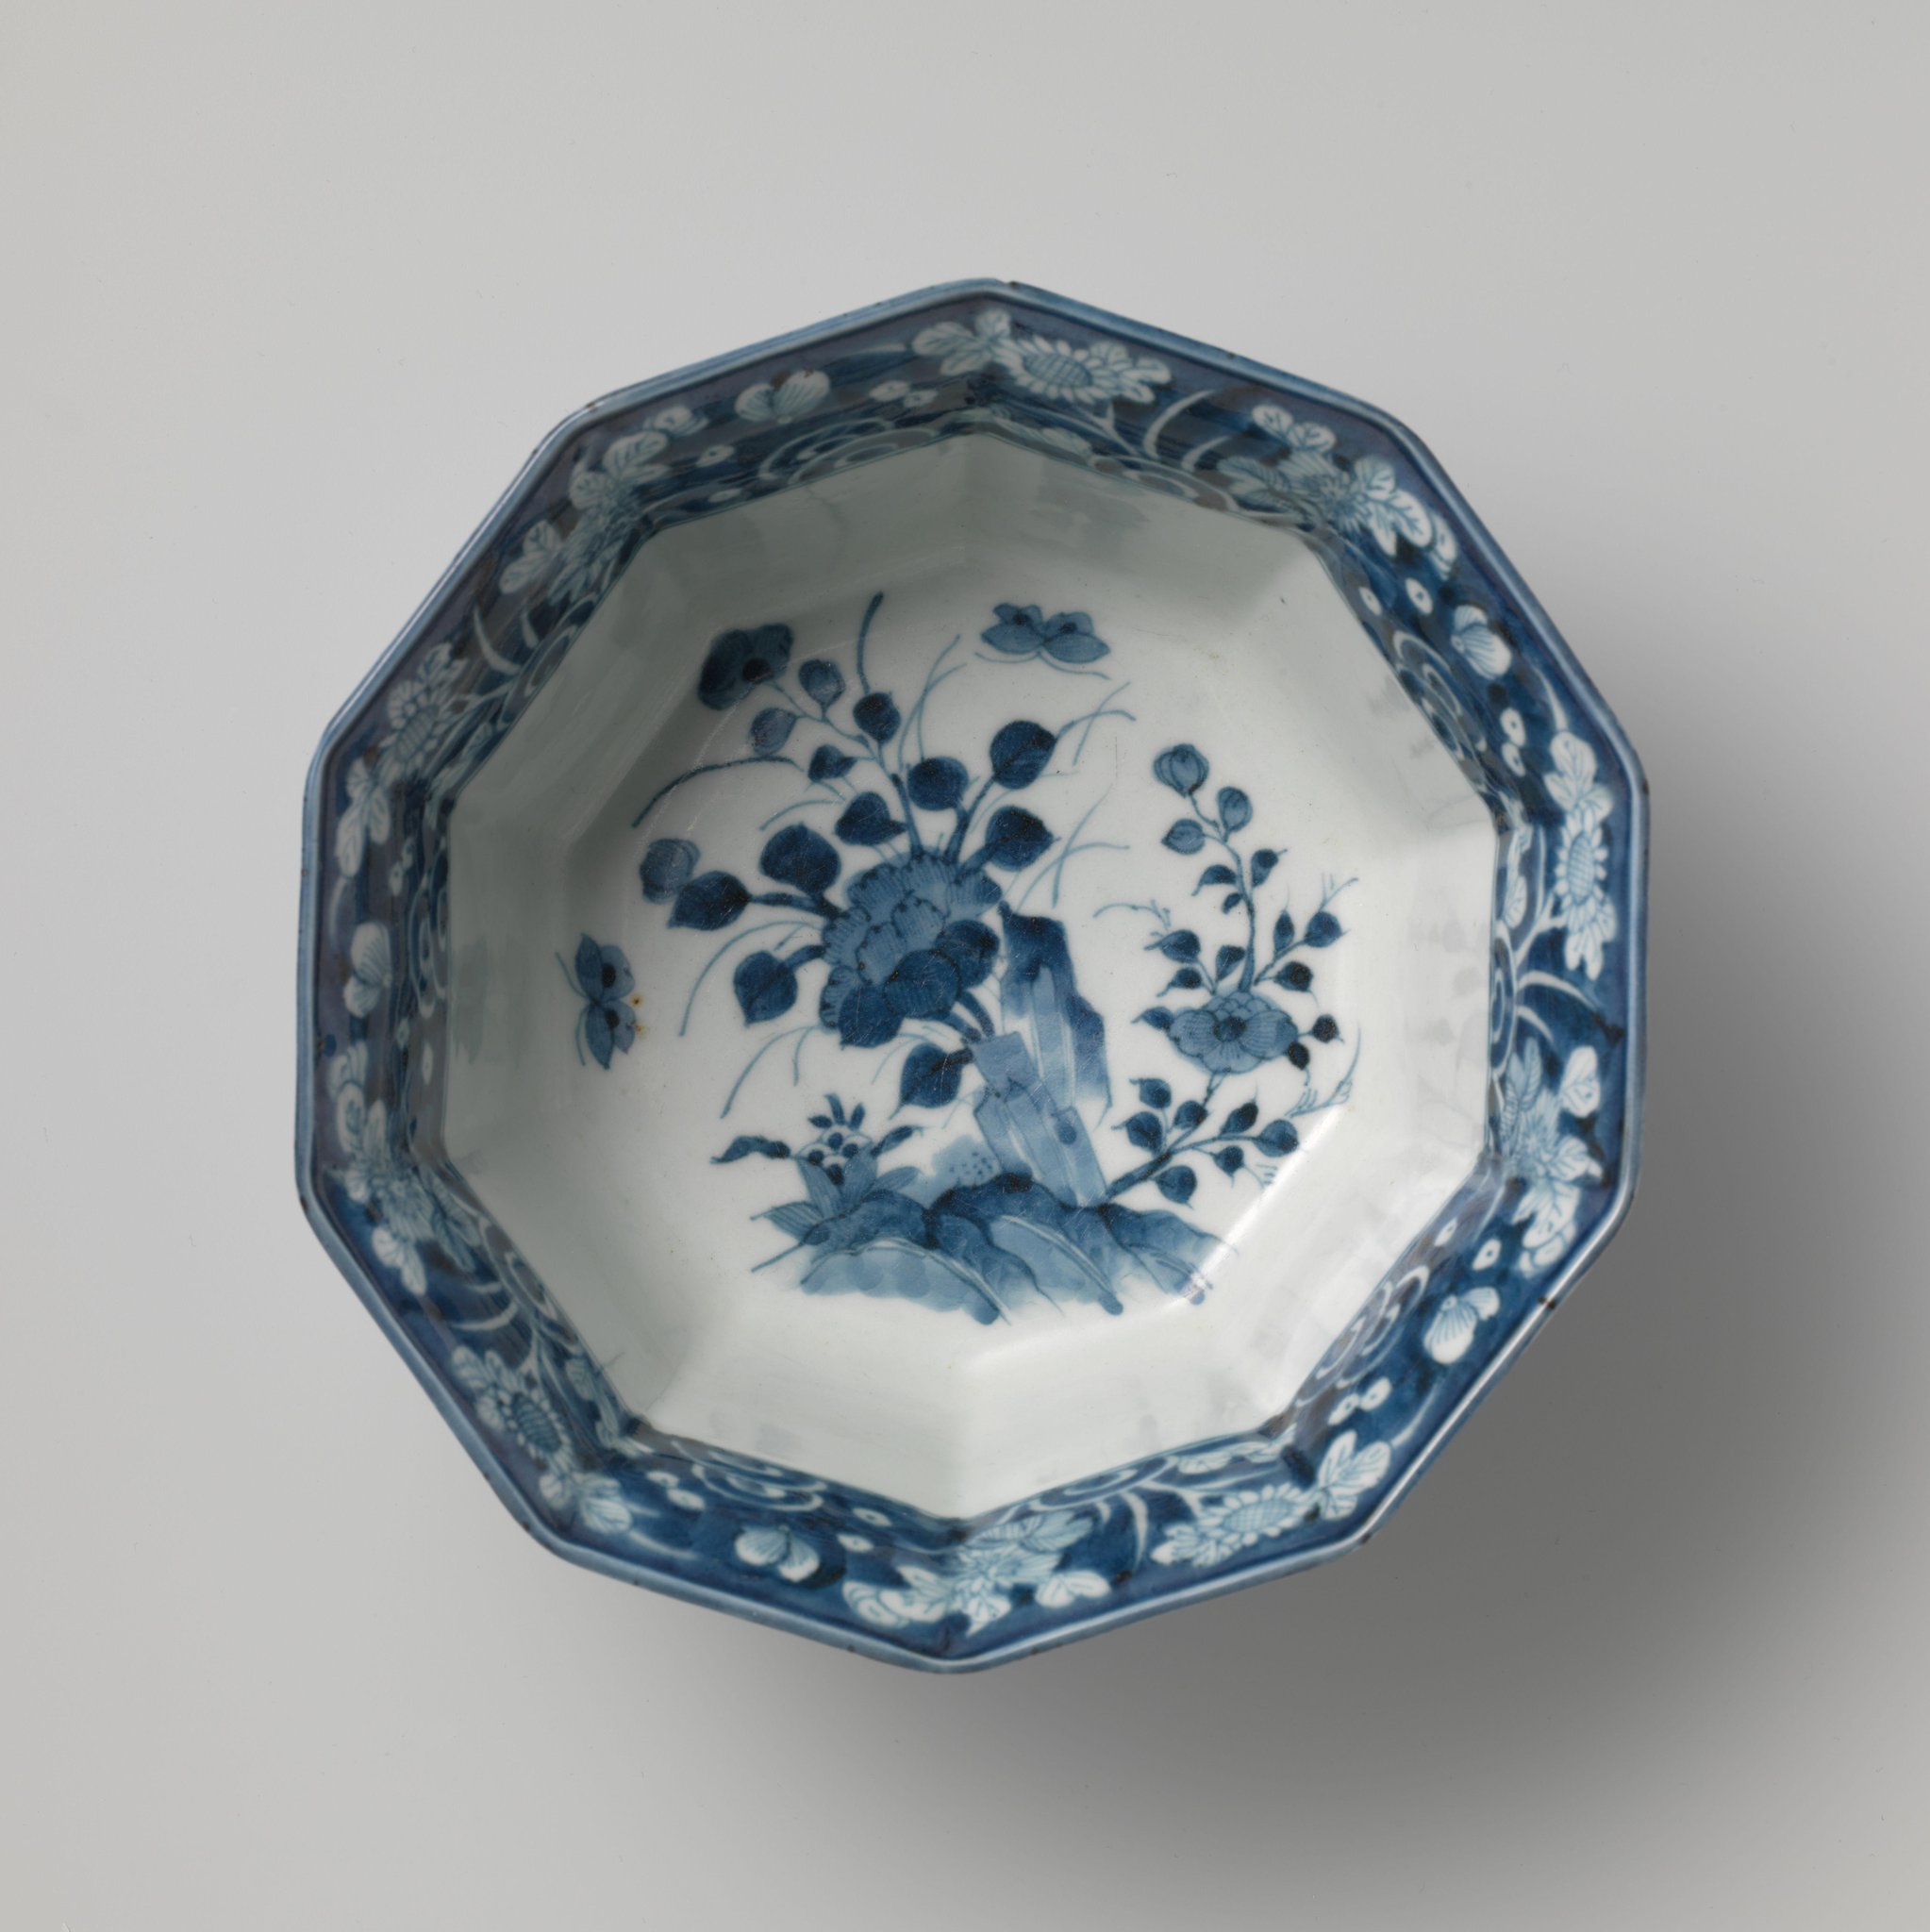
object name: bowl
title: Decagonal bowl with flowering plants near rocks, butterflies and floral scrolls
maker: Anonymous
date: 1700-1799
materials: cobalt, glaze, paint, porcelain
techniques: firing, forming, turning, vitrification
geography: japan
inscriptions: mark: ‘Fuku’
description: Tienhoekige kom van porselein, beschilderd in onderglazuur blauw. Op de buitenwand een doorlopende voorstelling van viermaal een bloeiende plant (chrysant, zonnebloem) bij rotsen; de buitenrand met een band met blauw wolkmotief met daarin uitgespaard vlinders. Op de bodem een pioenplant bij een rots en twee vliegende vlinders. De binnenrand met een brede, blauwe band met daarin uitgespaard zonnebloemen, chrysanten en vlinders. Gemerkt op de onderzijde met 'fuku' in een dubbel vierkant. Arita, blauw-wit.